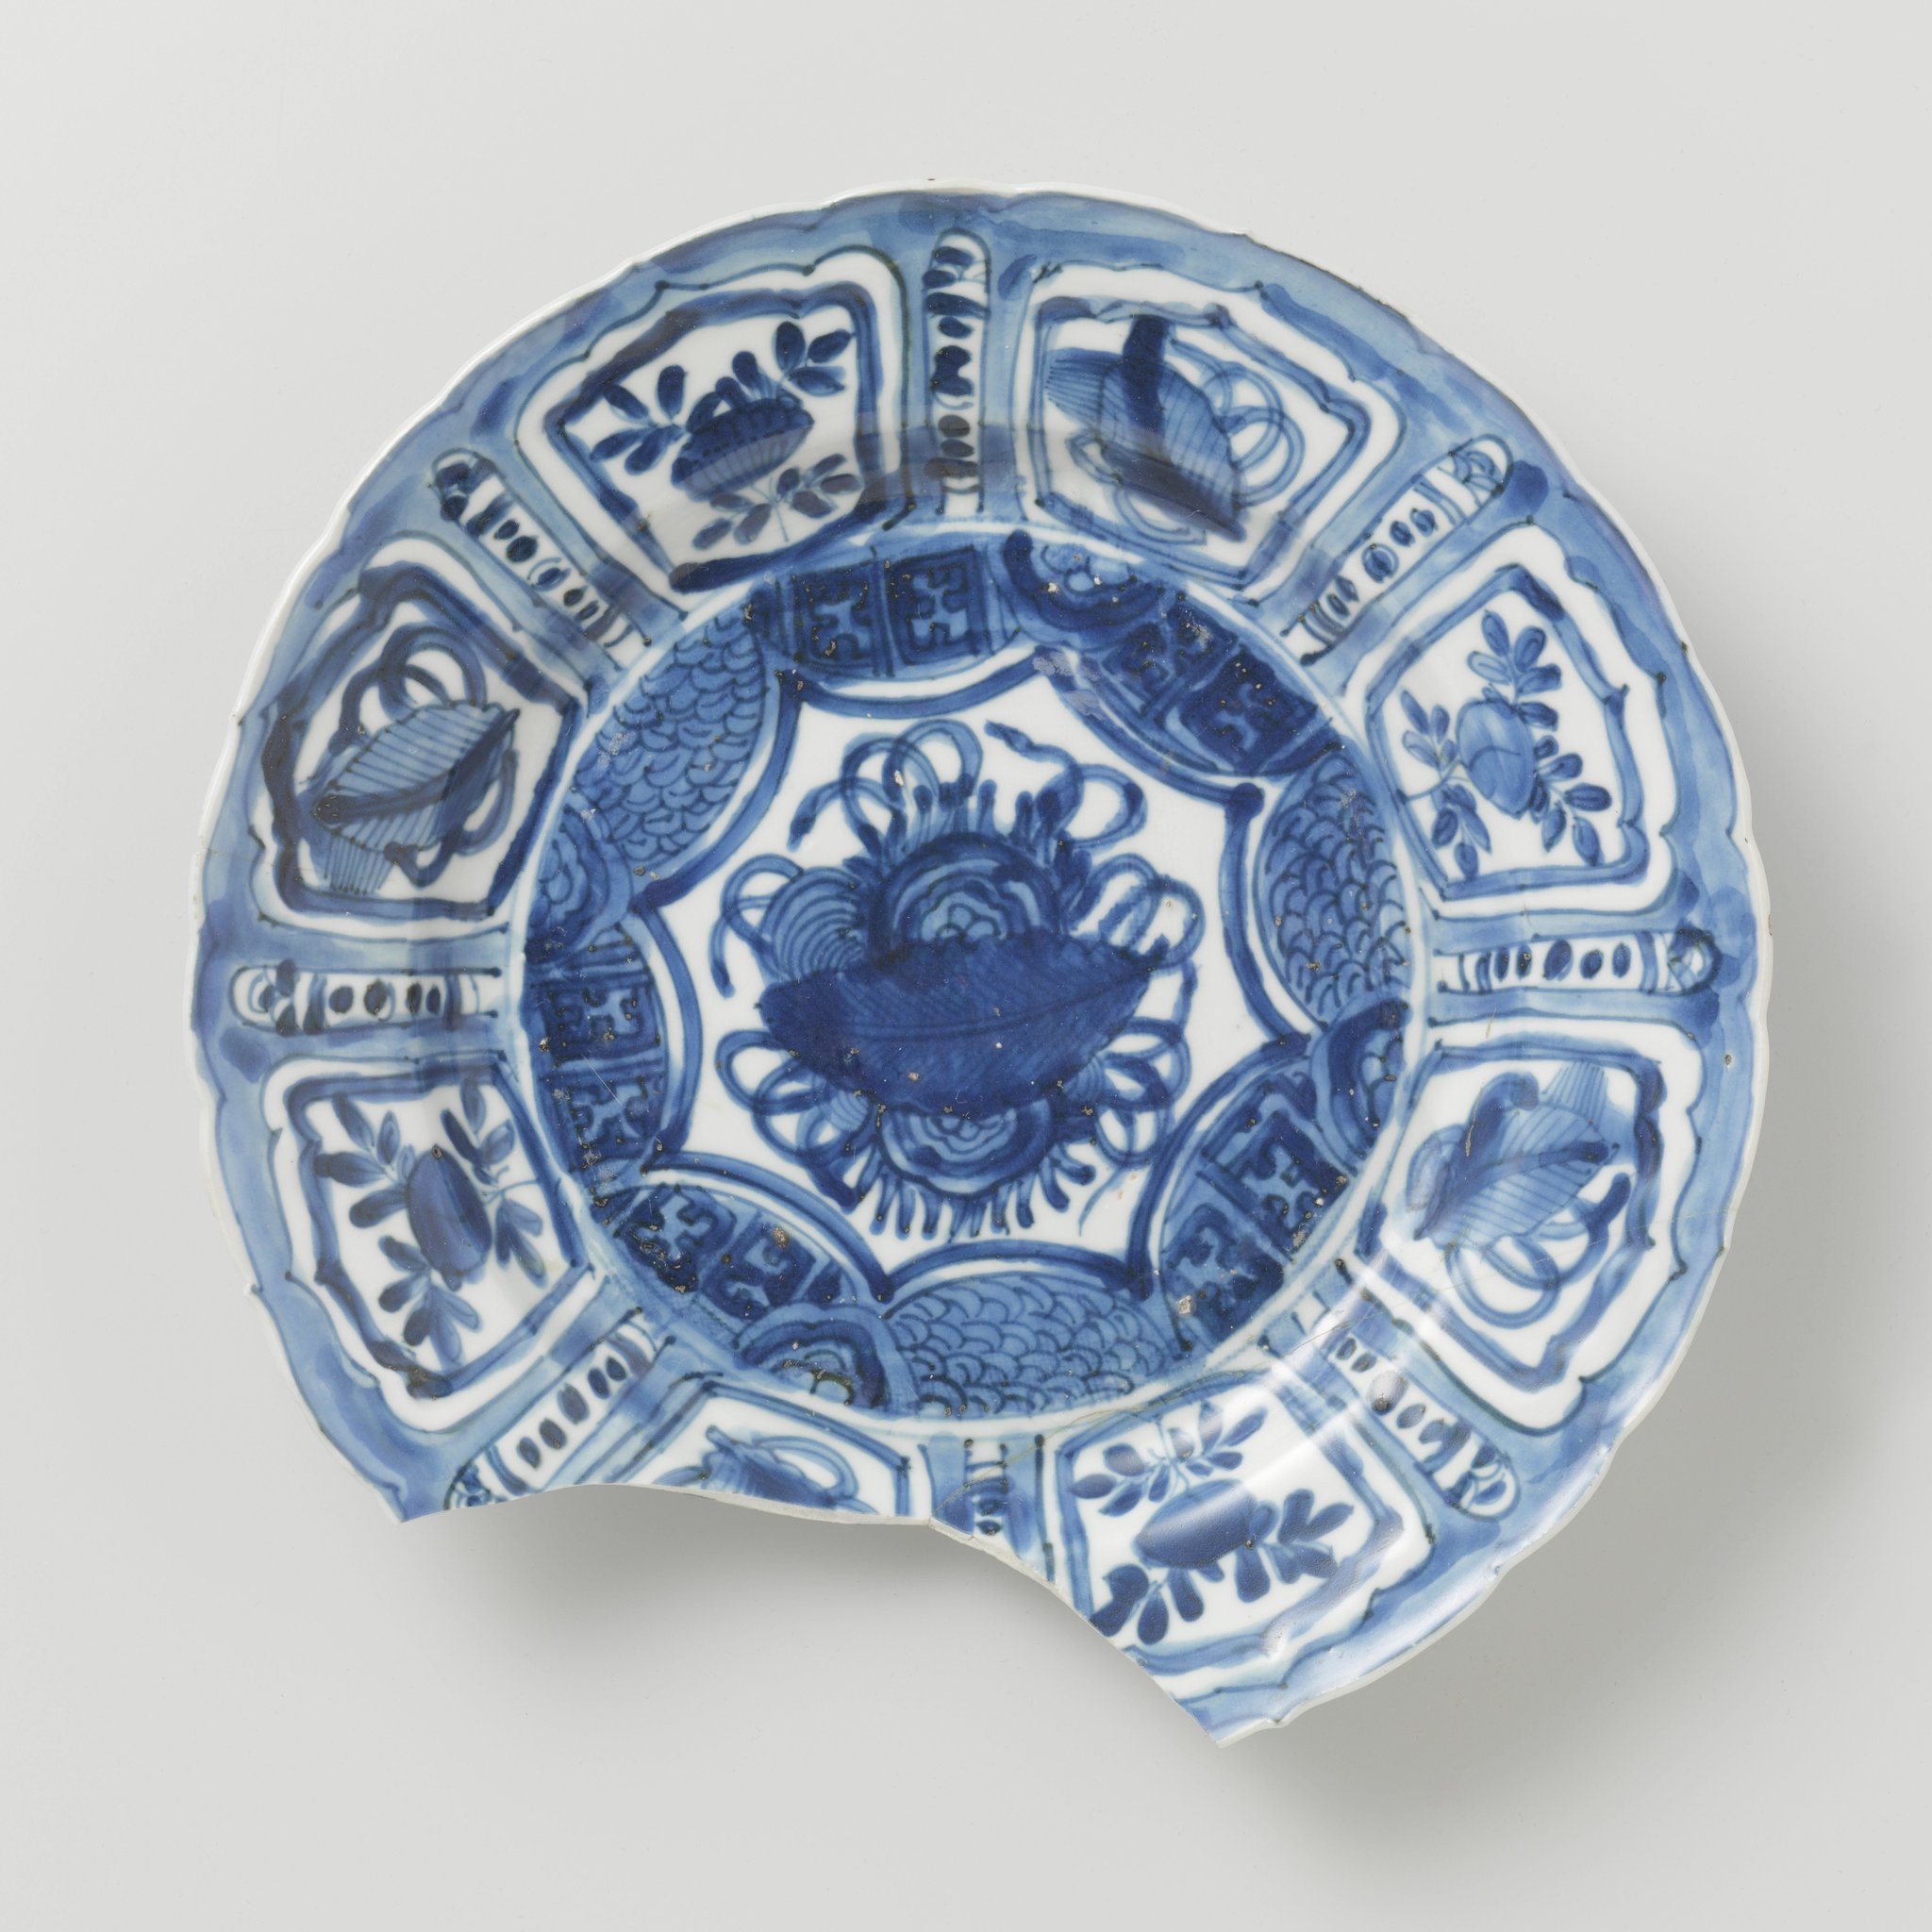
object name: plate dish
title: Kraak porcelain plate from the V.O.C.-ship the 'Witte Leeuw'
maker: Anonymous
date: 1613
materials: bone china, cobalt, glaze, paint, porcelain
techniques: firing, turning, vitrification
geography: china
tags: verenigde oostindische compagnie, sint-helena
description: A plate with a flattened rim. A star-shaped medallion with 4 rui heads and various diaper patterns. These plates all have a central decoration of symbols; thedecoration on cavetto and rim are also similar. Another typical feature of these plates is the pattern resemblimg the imprint of woven cloth in the centre, under the glaze. A central decoration of symbols. Panels decorated with flowers, peaches and symbols.